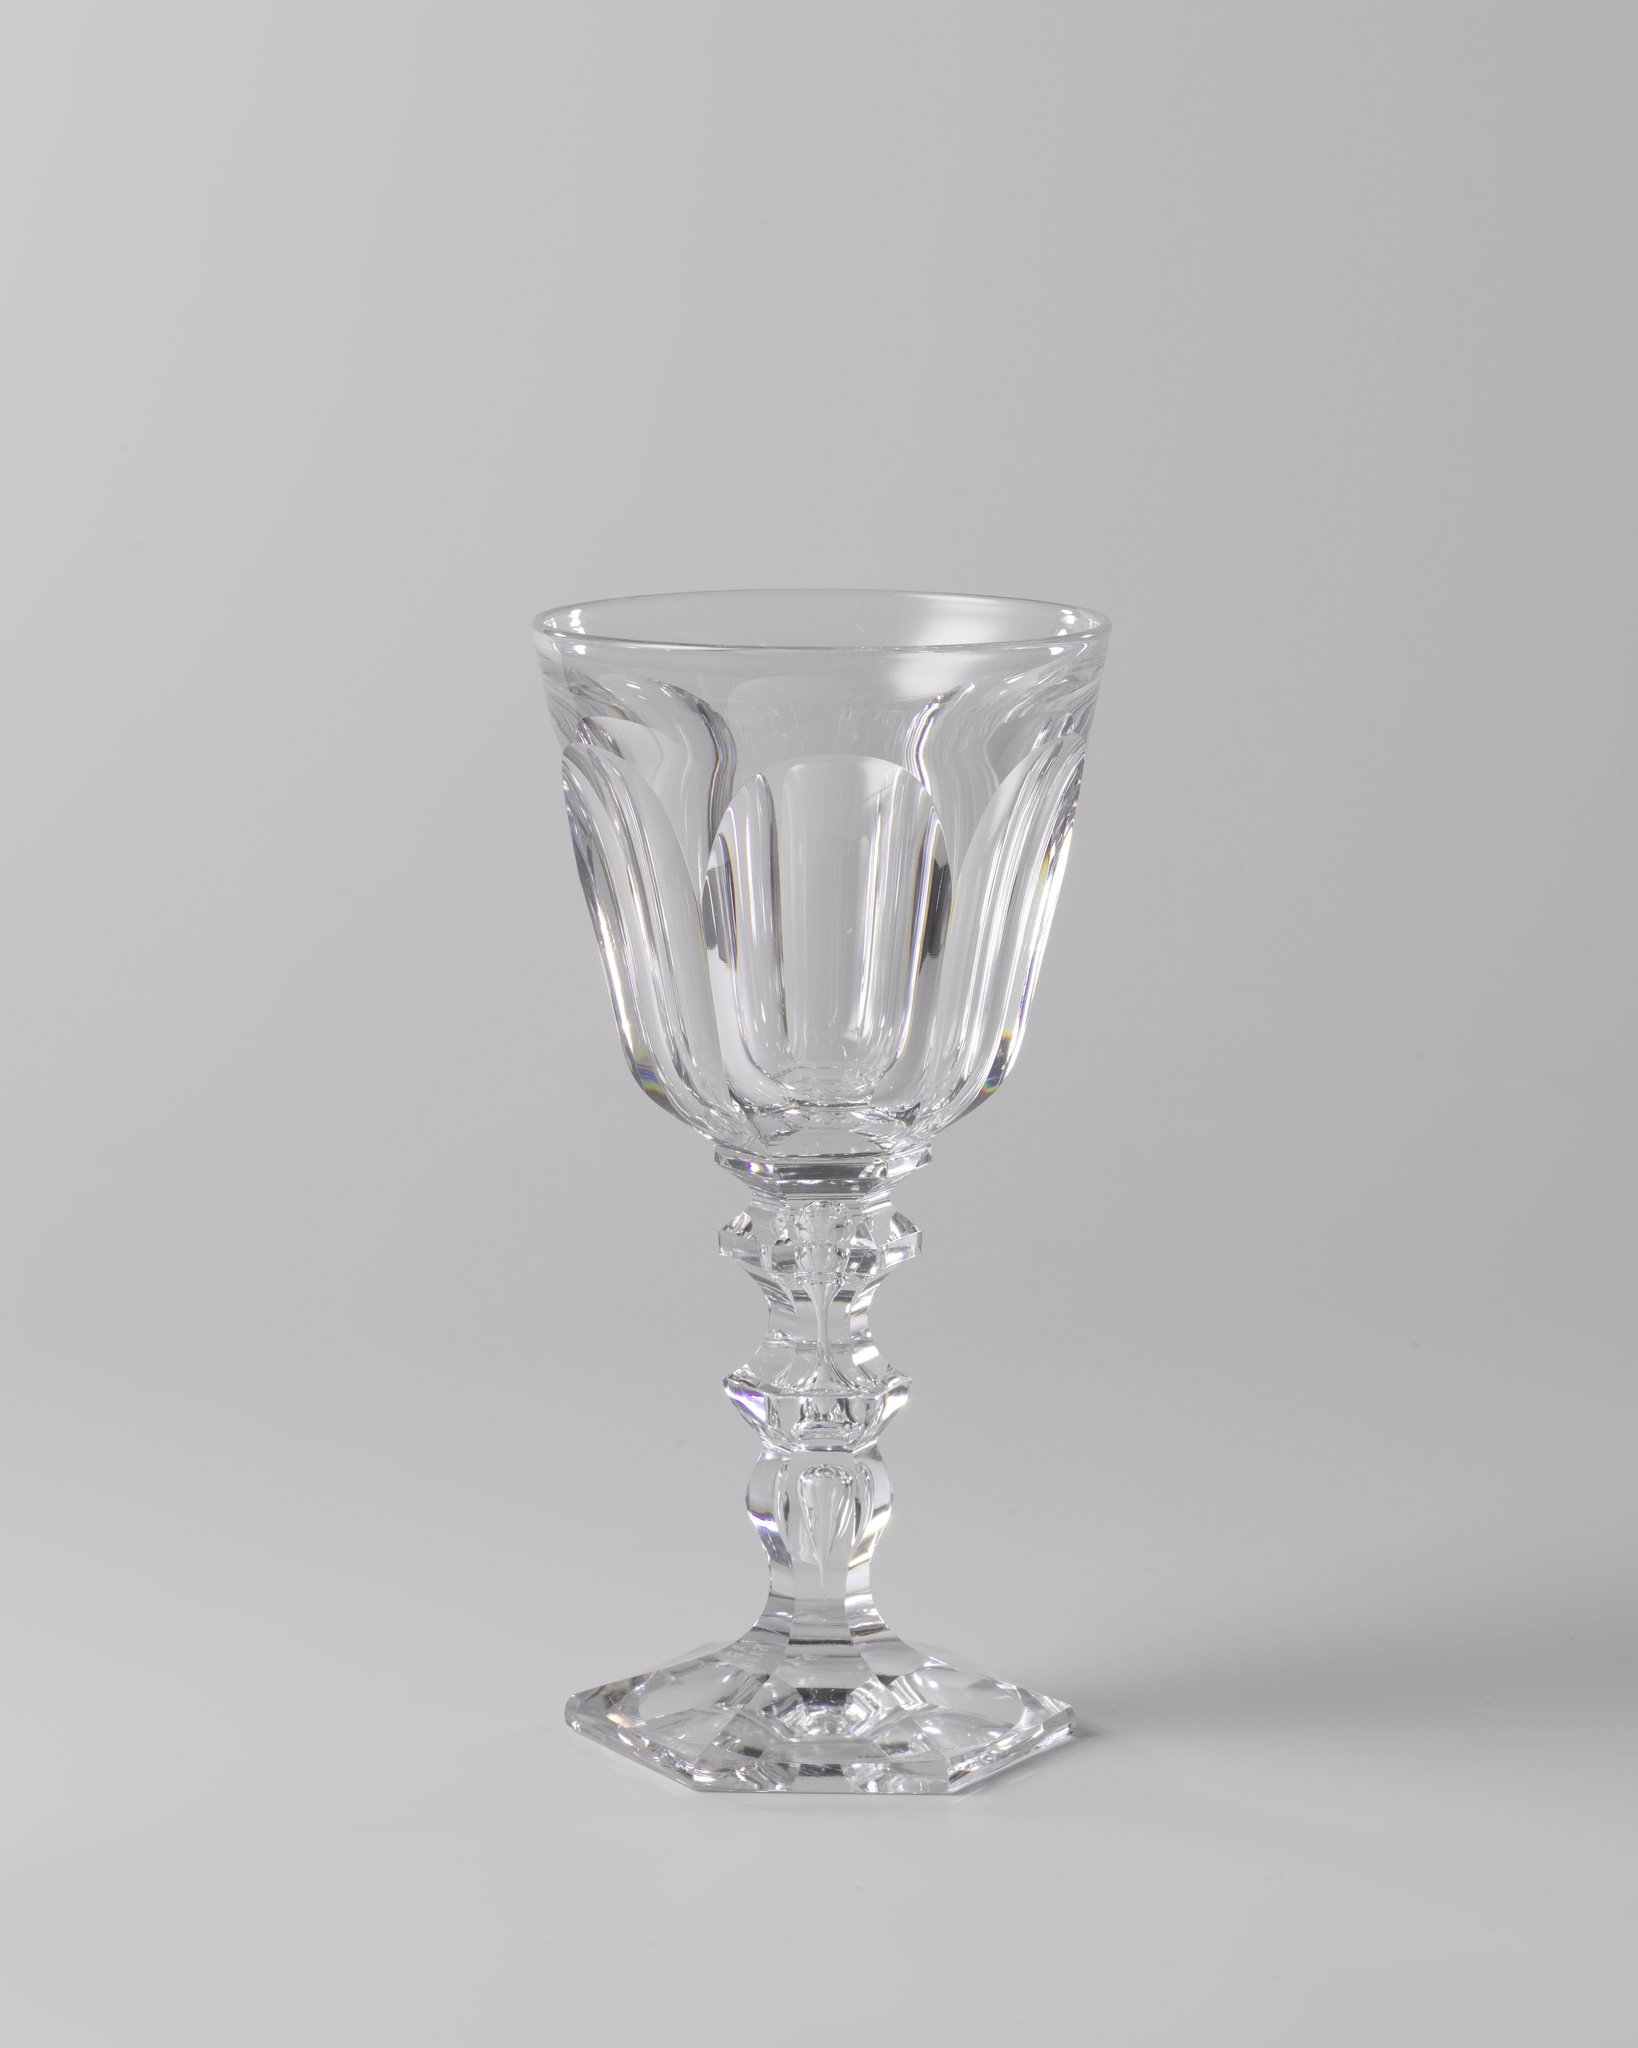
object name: goblet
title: Kelkglas met geslepen elipsen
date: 1850-1875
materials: glass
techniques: glassblowing, grinding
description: Zeshoekige, conische voet, balustervormige stam met een ingesloten luchtbel en twee knopen. Conische, aan de onderzijde afgeronde kelk. Facetgeslepen voet en stam, kelk in ellipsen geslepen.